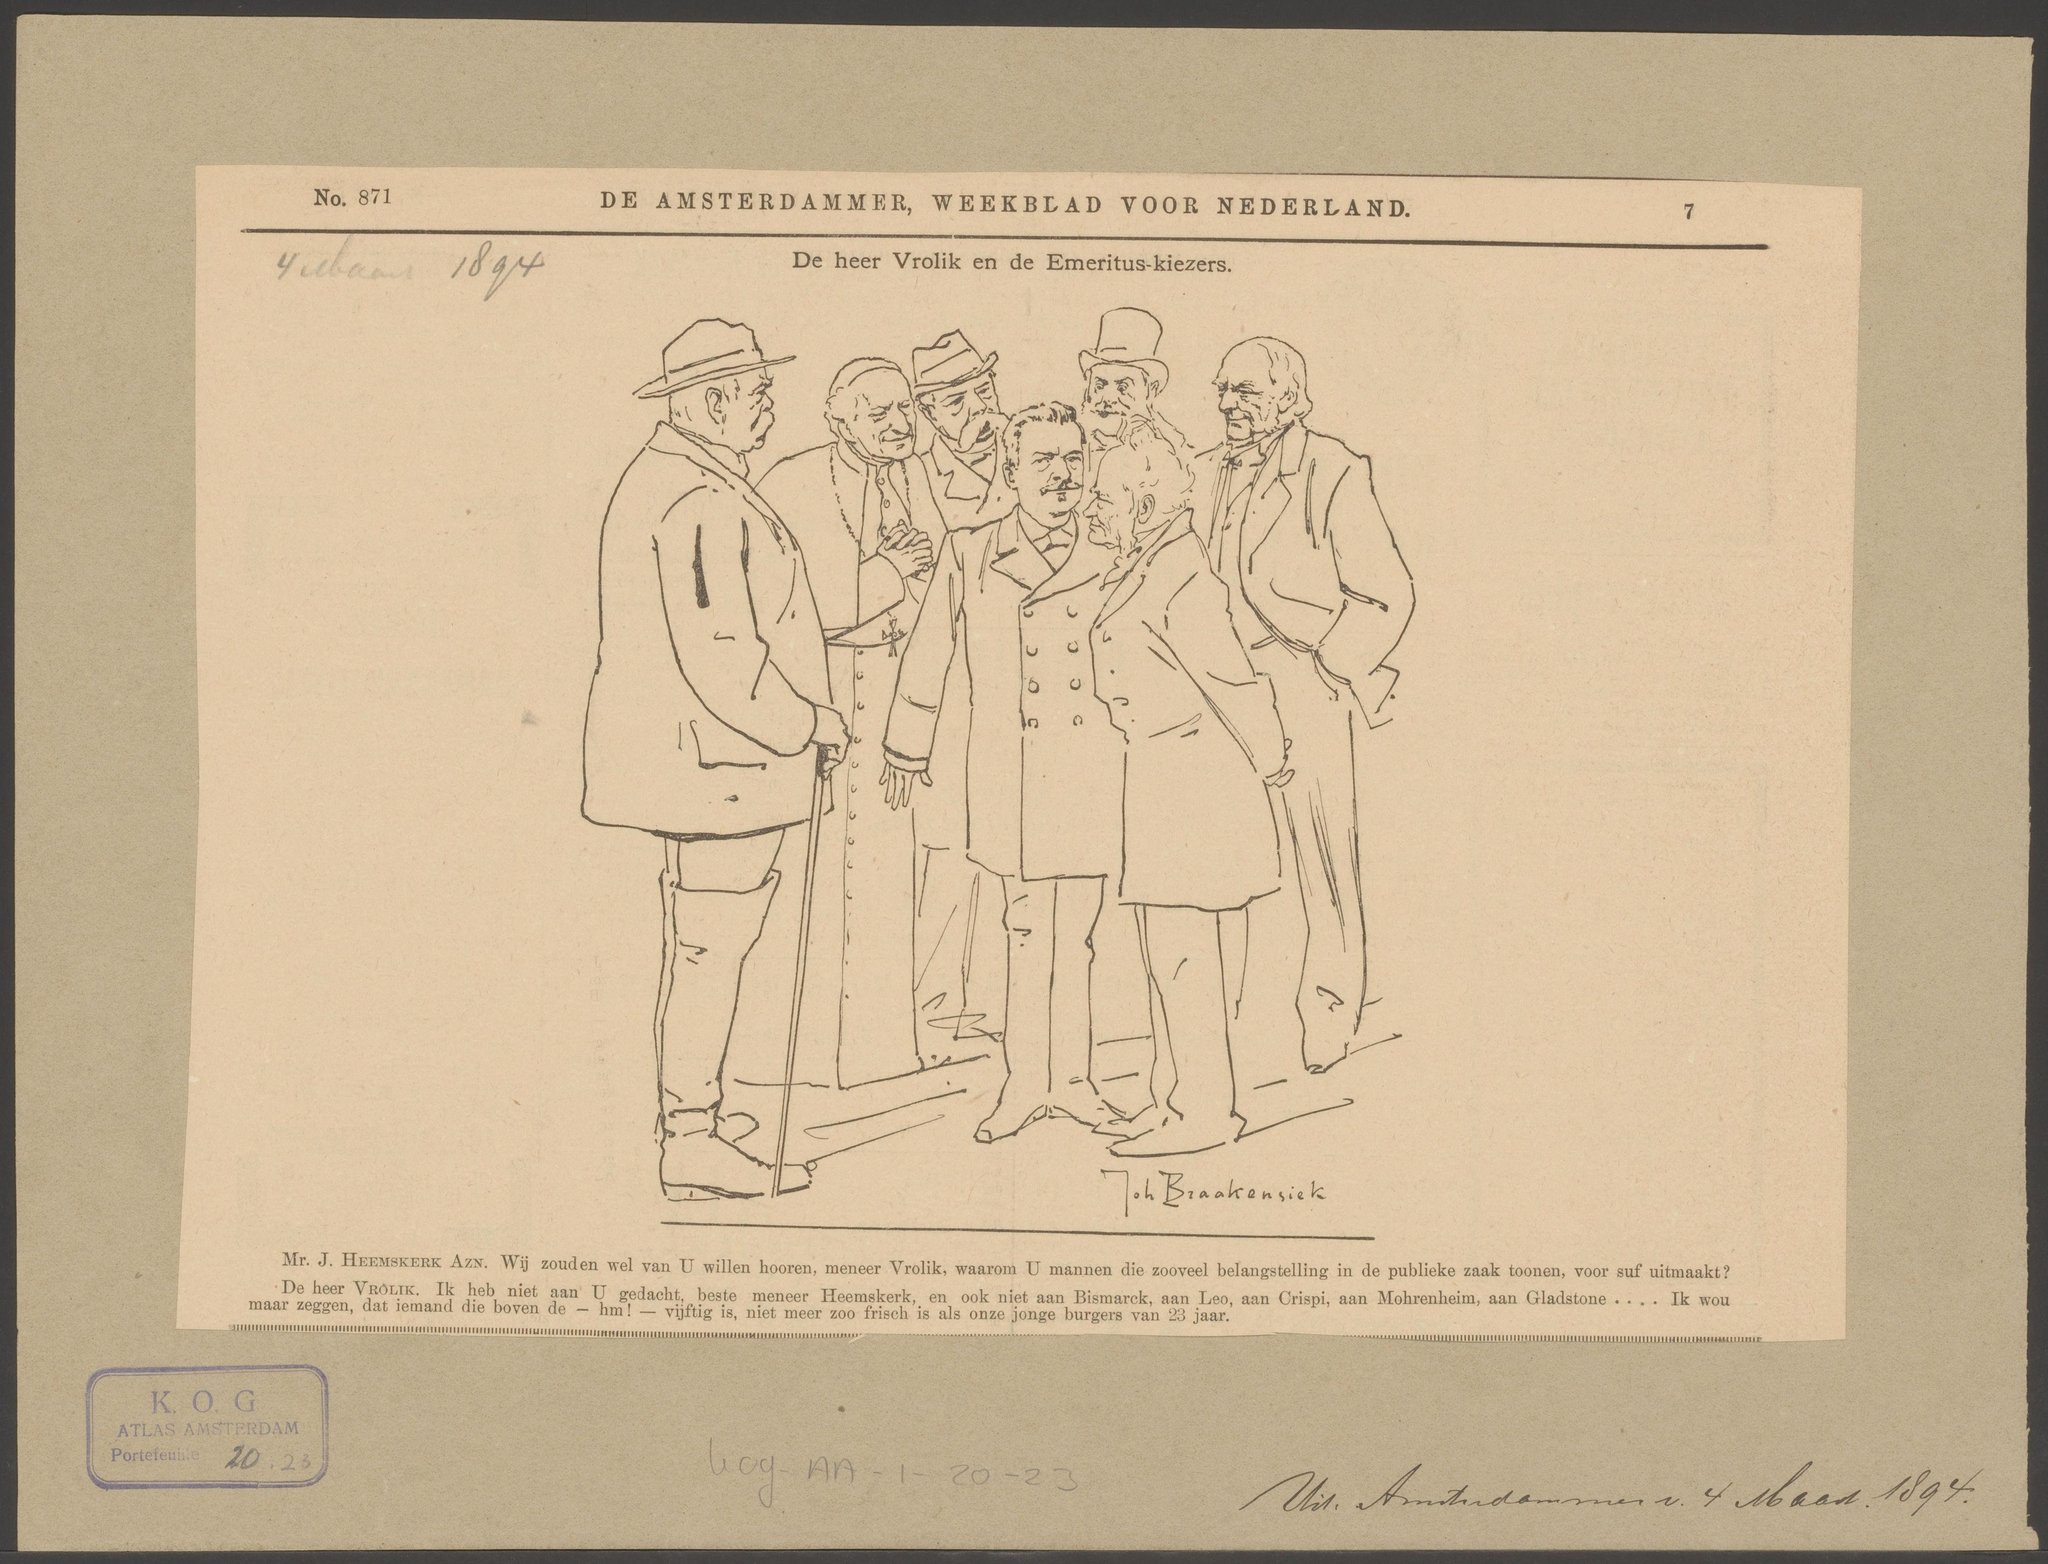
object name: photomechanical print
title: De heer Vrolik en de Emeritus-kiezers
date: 1894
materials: paper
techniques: line block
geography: amsterdam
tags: rome, leo xiii, amsterdam, the hague, politician, liverpool, naples, politician, e.g. party leader, political caricatures and satires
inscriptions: collector's mark: Lugt 1641b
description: Onderwerpsrubriek binnen de Atlas Amsterdam: Verkiezingen Tweede Kamer.